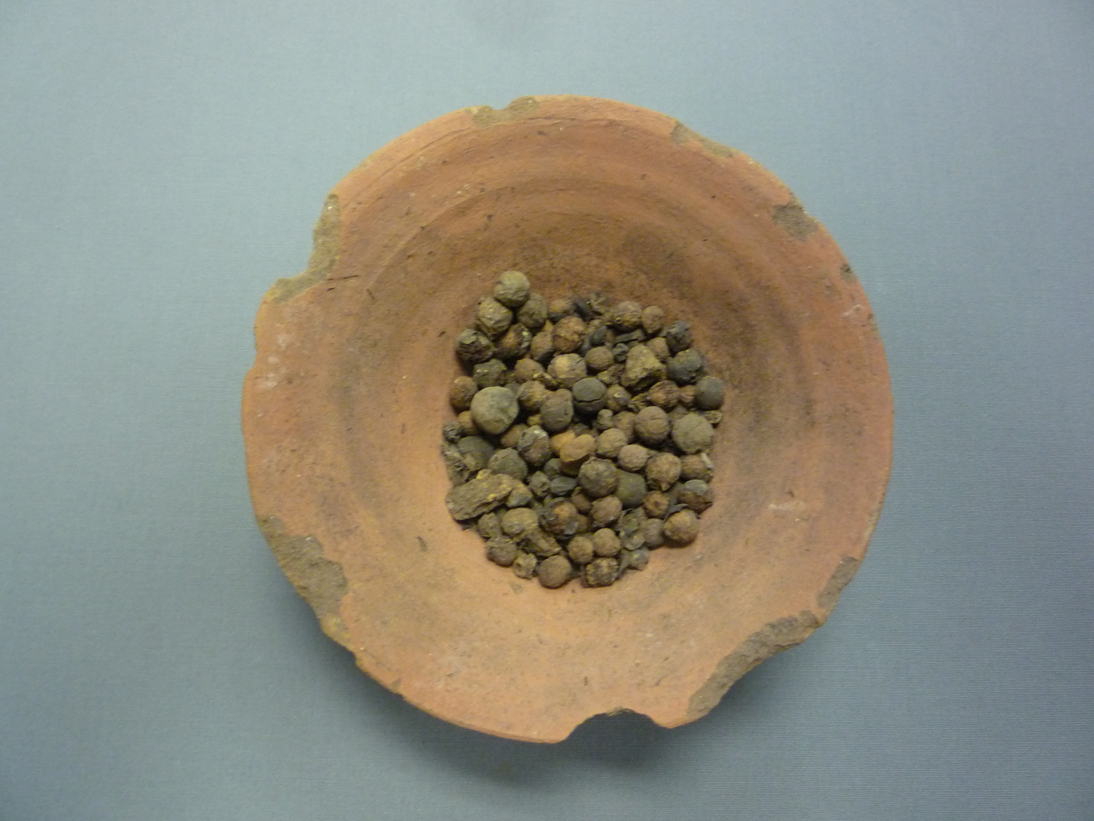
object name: bowl, jujube berry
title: Bowl of Jujube Berries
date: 1479-1458 BCE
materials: pottery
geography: egypt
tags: fruit